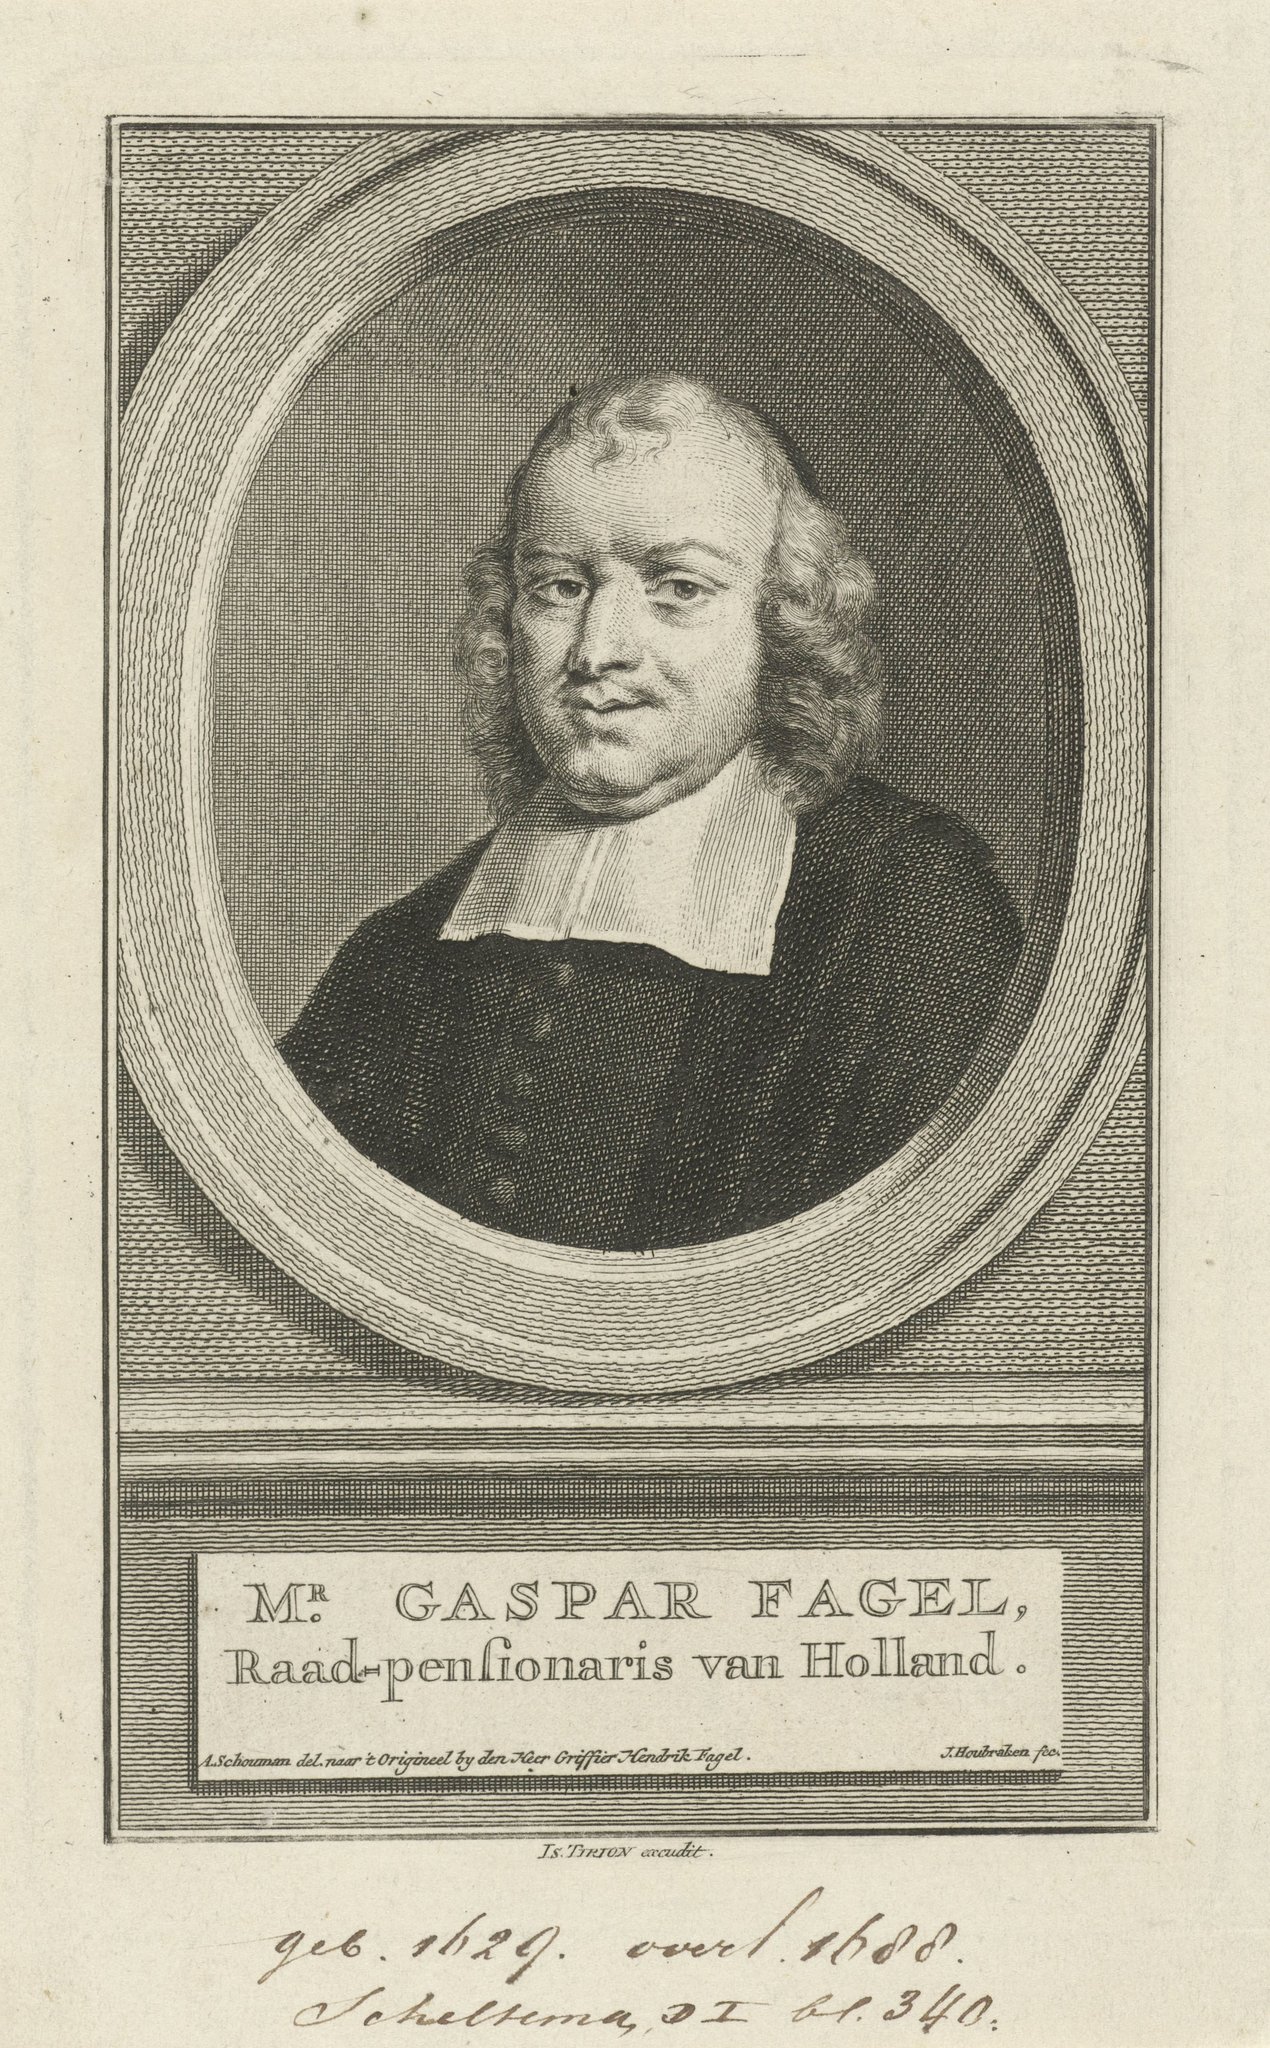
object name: print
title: Mr. Gaspar Fagel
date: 1749-1759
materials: paper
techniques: engraving, etching, pen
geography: amsterdam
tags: the hague, politician, gaspar fagel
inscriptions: inscription: ‘geb. 1629 overl. 1688/ Scheltema, D I bl. 340’, collector's mark: Lugt 2228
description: Prent ook gebruikt in: Jan Wagenaar, Vaderlandsche historie, vervattende de geschiedenissen der nu Vereenigde Nederlanden, inzonderheid die van Holland (...), 21 delen. Amsterdam, Isaak Tirion, 1749-59.